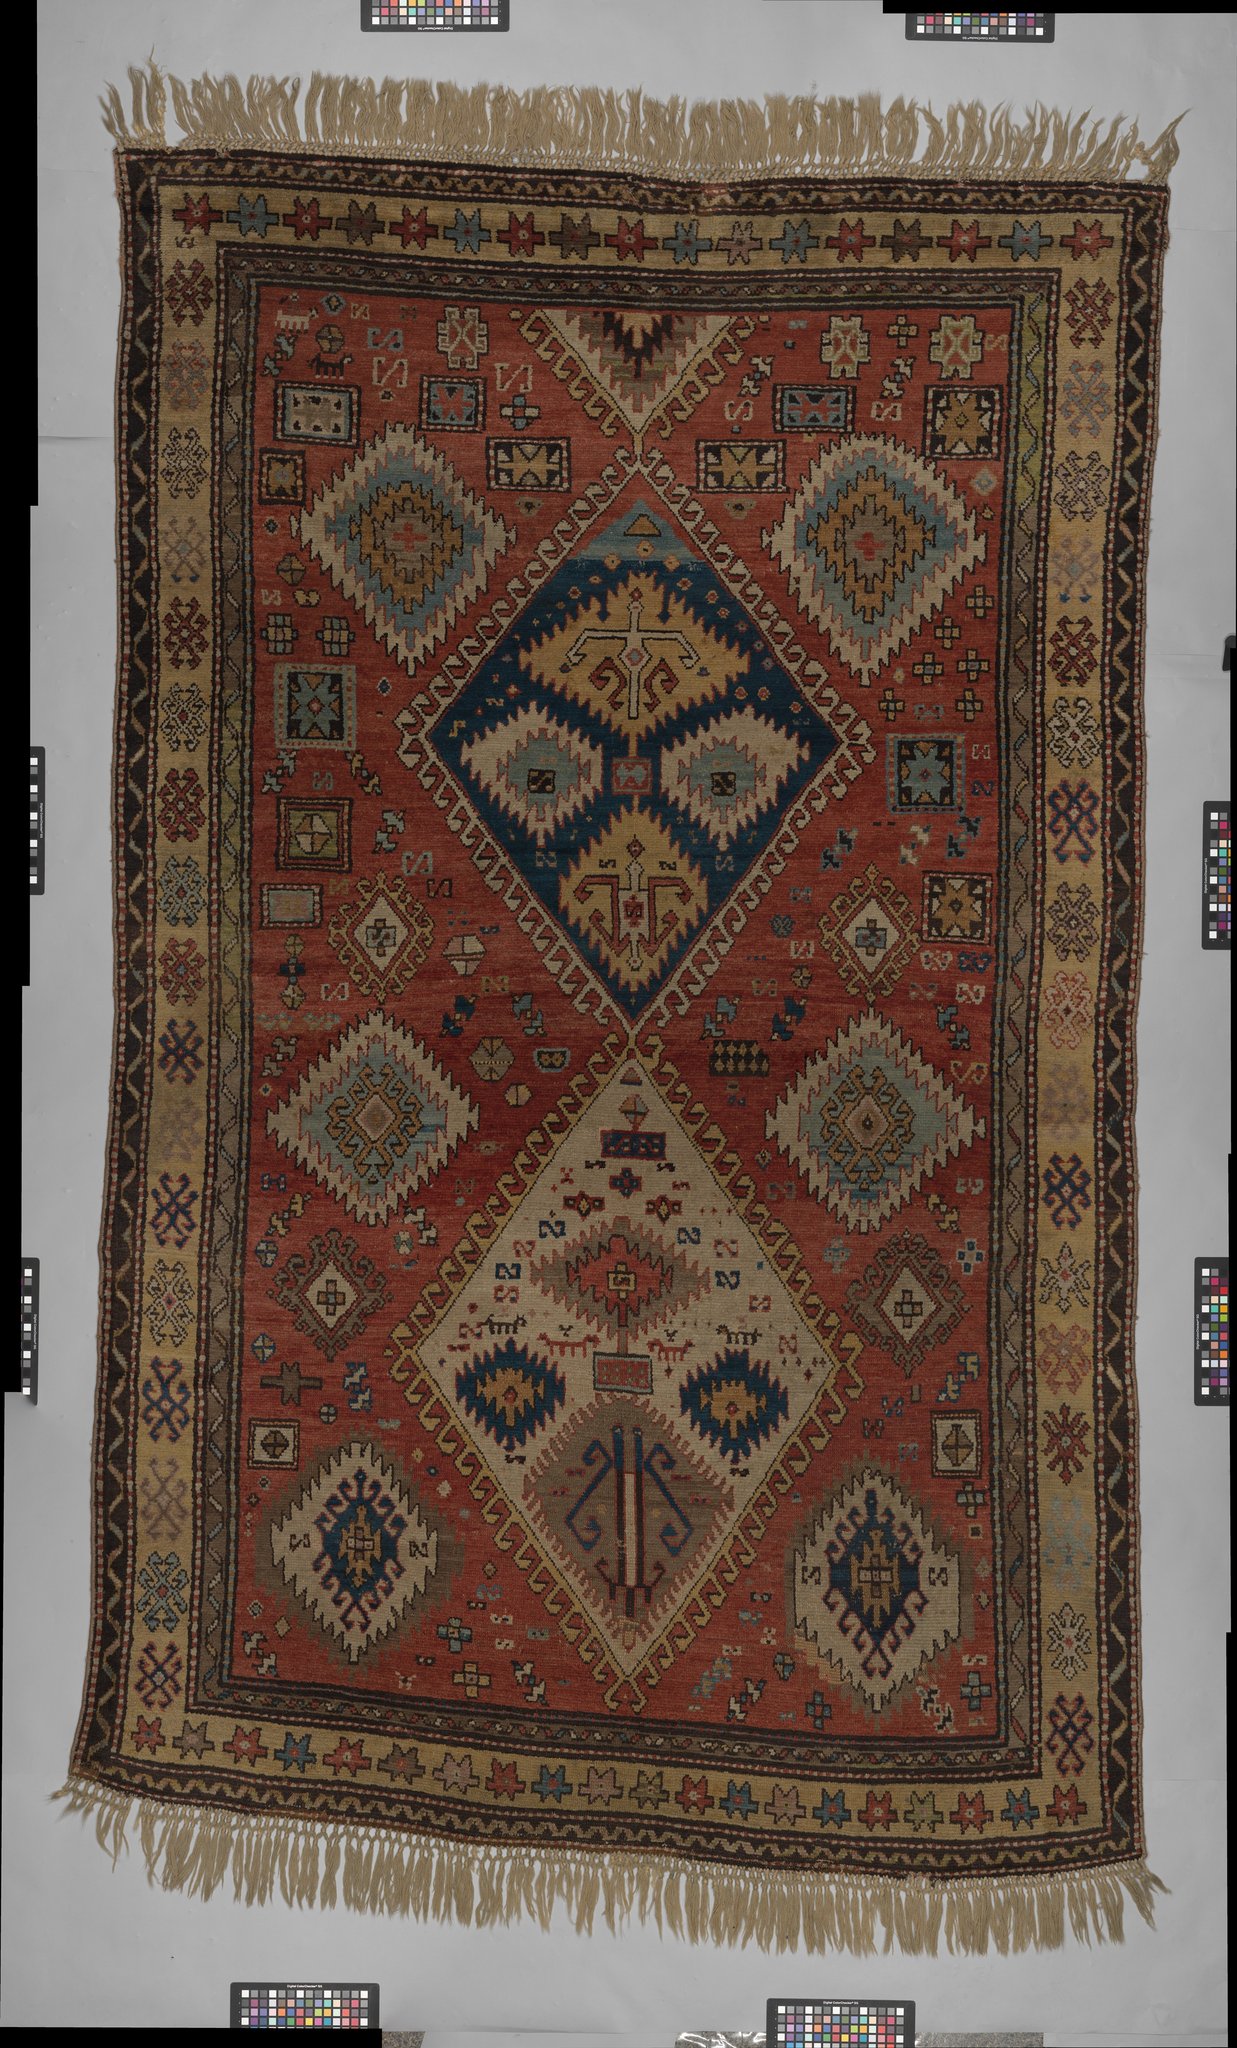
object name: carpet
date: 1801-1900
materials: wool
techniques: pile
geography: caucasus